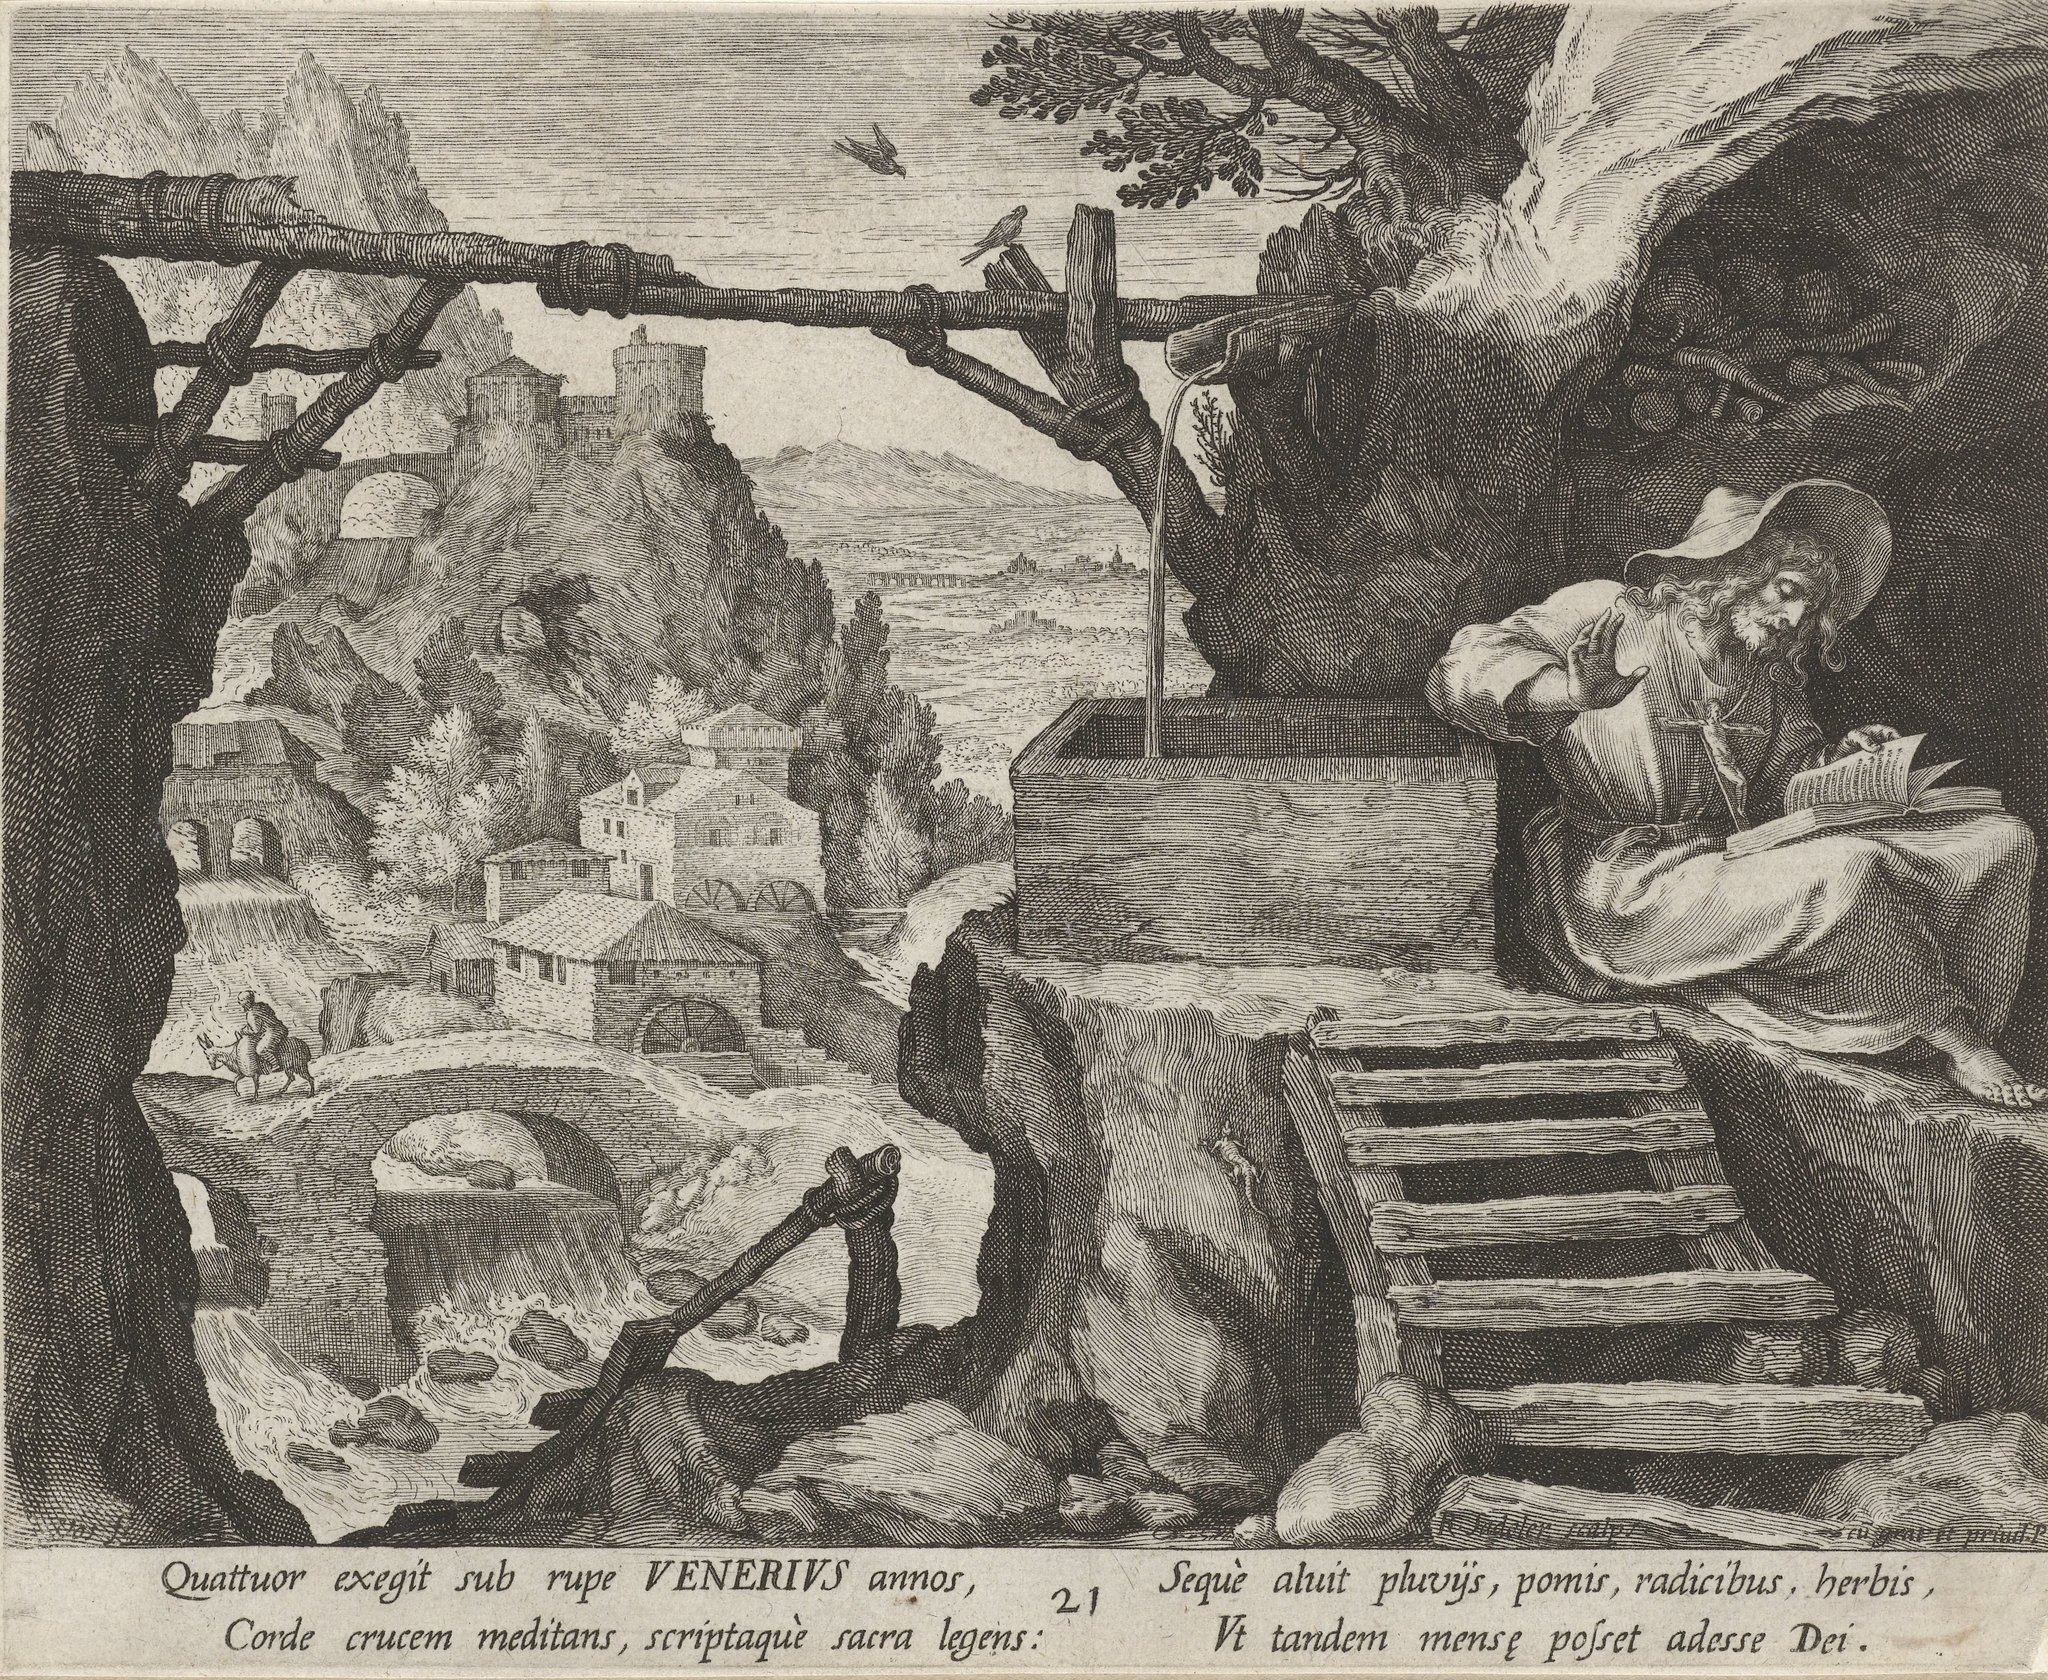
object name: print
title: Het deugdzame leven van kluizenaars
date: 1598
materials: paper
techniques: engraving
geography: venice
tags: sink, basin, male saints (with name), anchorite, hermit, landscape with bridge, viaduct or aqueduct (+ city(-scape) with figures, staffage), mountains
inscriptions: collector's mark: Lugt 240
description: De H. Venerius van Tino, een Italiaanse kluizenaar uit de zevende eeuw na Christus, zit bij een waterbassin en leest een bijbel. Op de achtergrond een bergachtig landschap met een brug over een rivier.